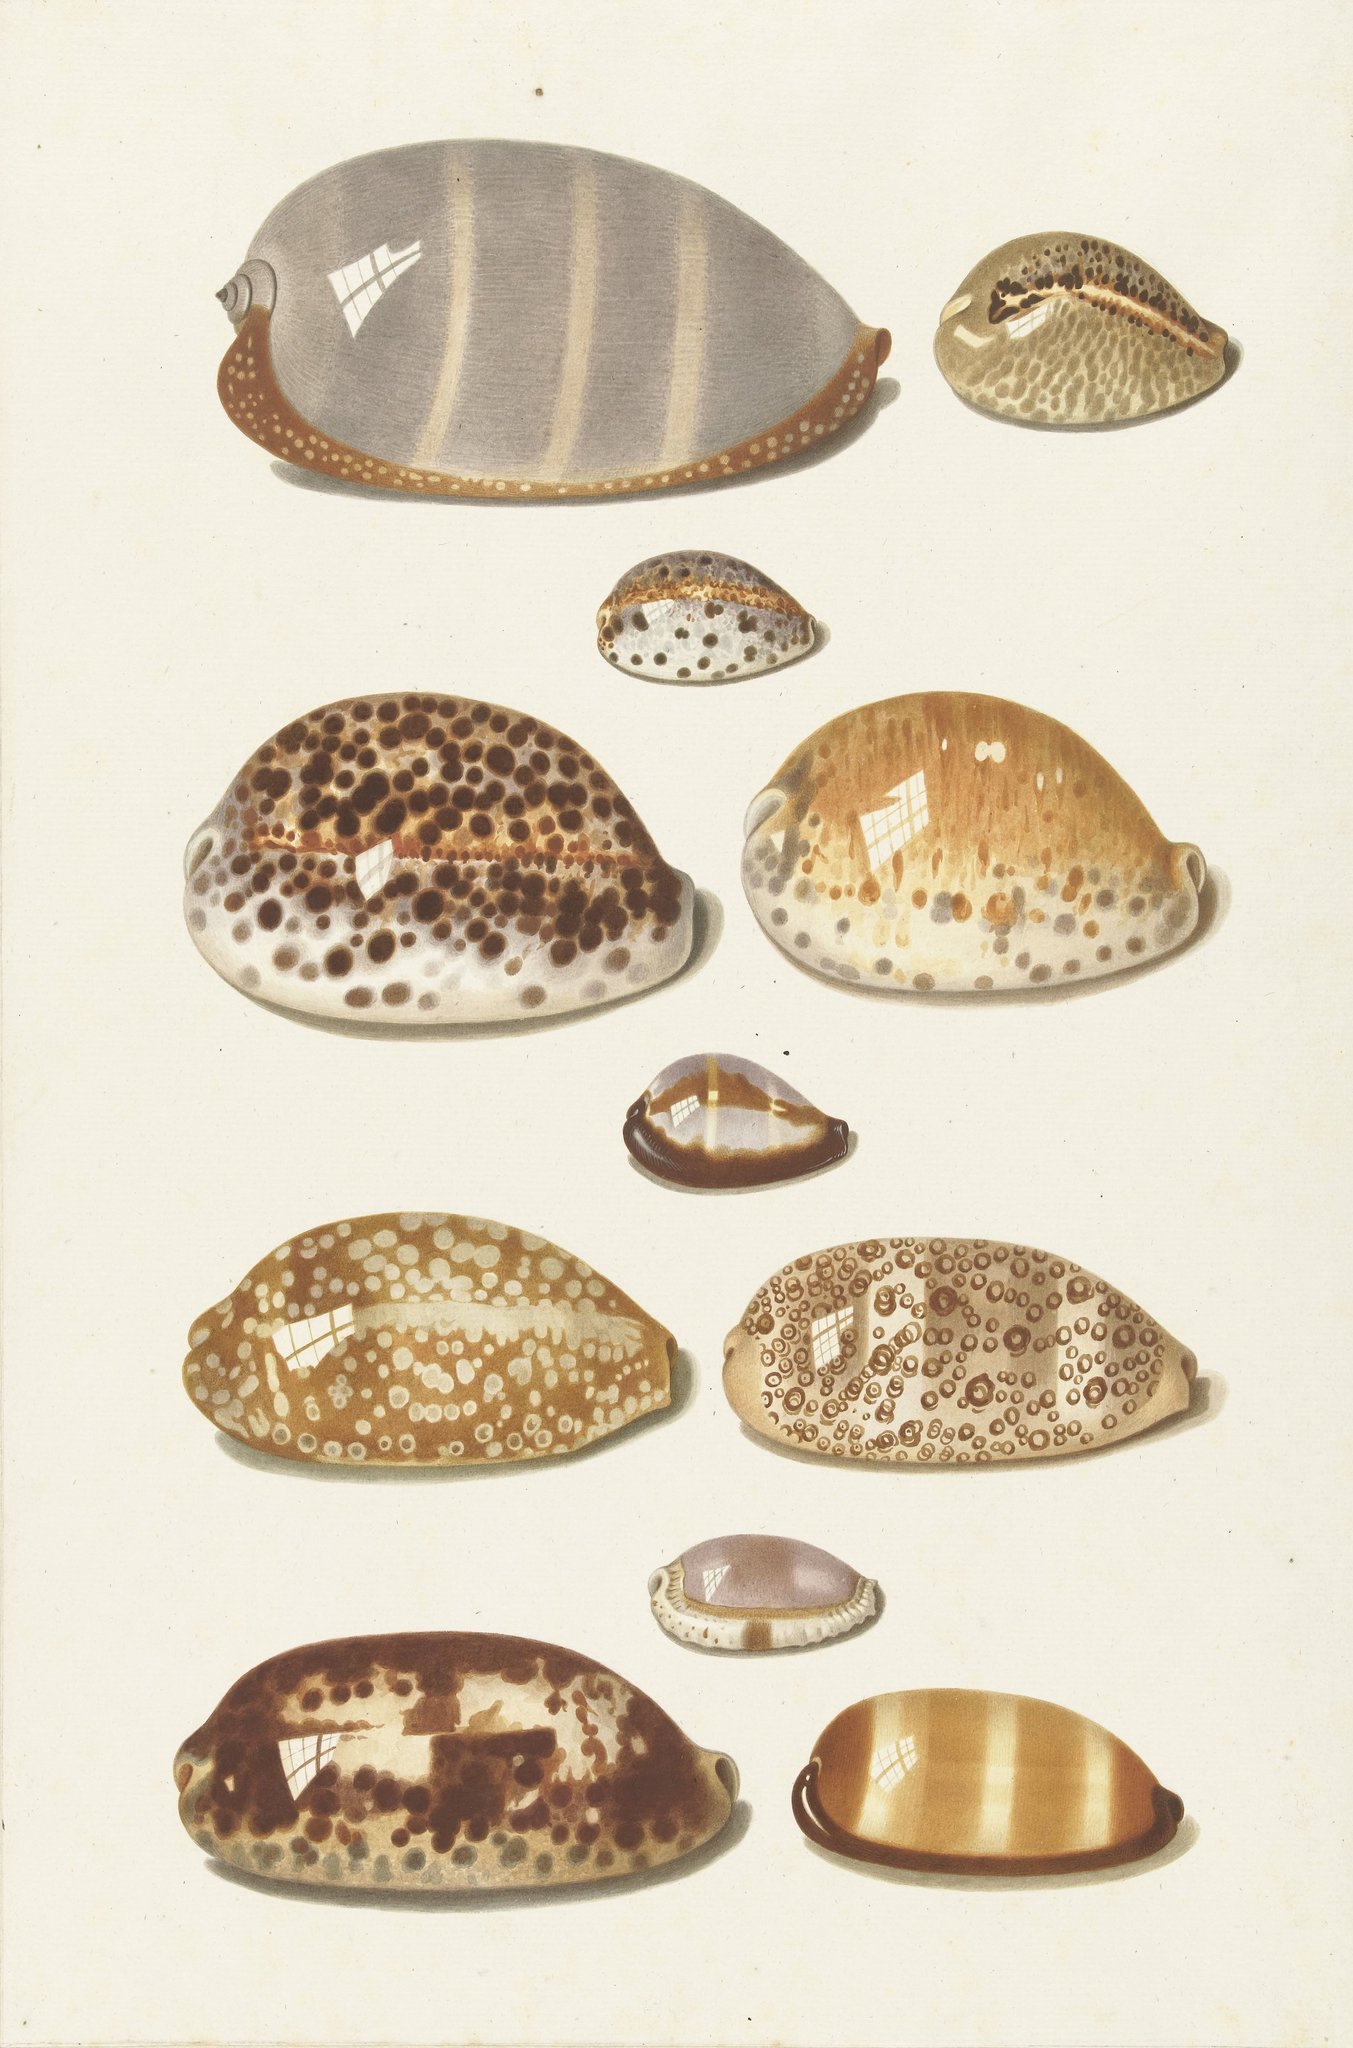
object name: watercolor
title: Elf grote en kleine tropische kaurie schelpen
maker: johann gustav hoch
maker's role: painter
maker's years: 1716-1779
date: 1726-1779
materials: paper, watercolor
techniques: brush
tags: molluscs (+ shell, snail-shell etc.)